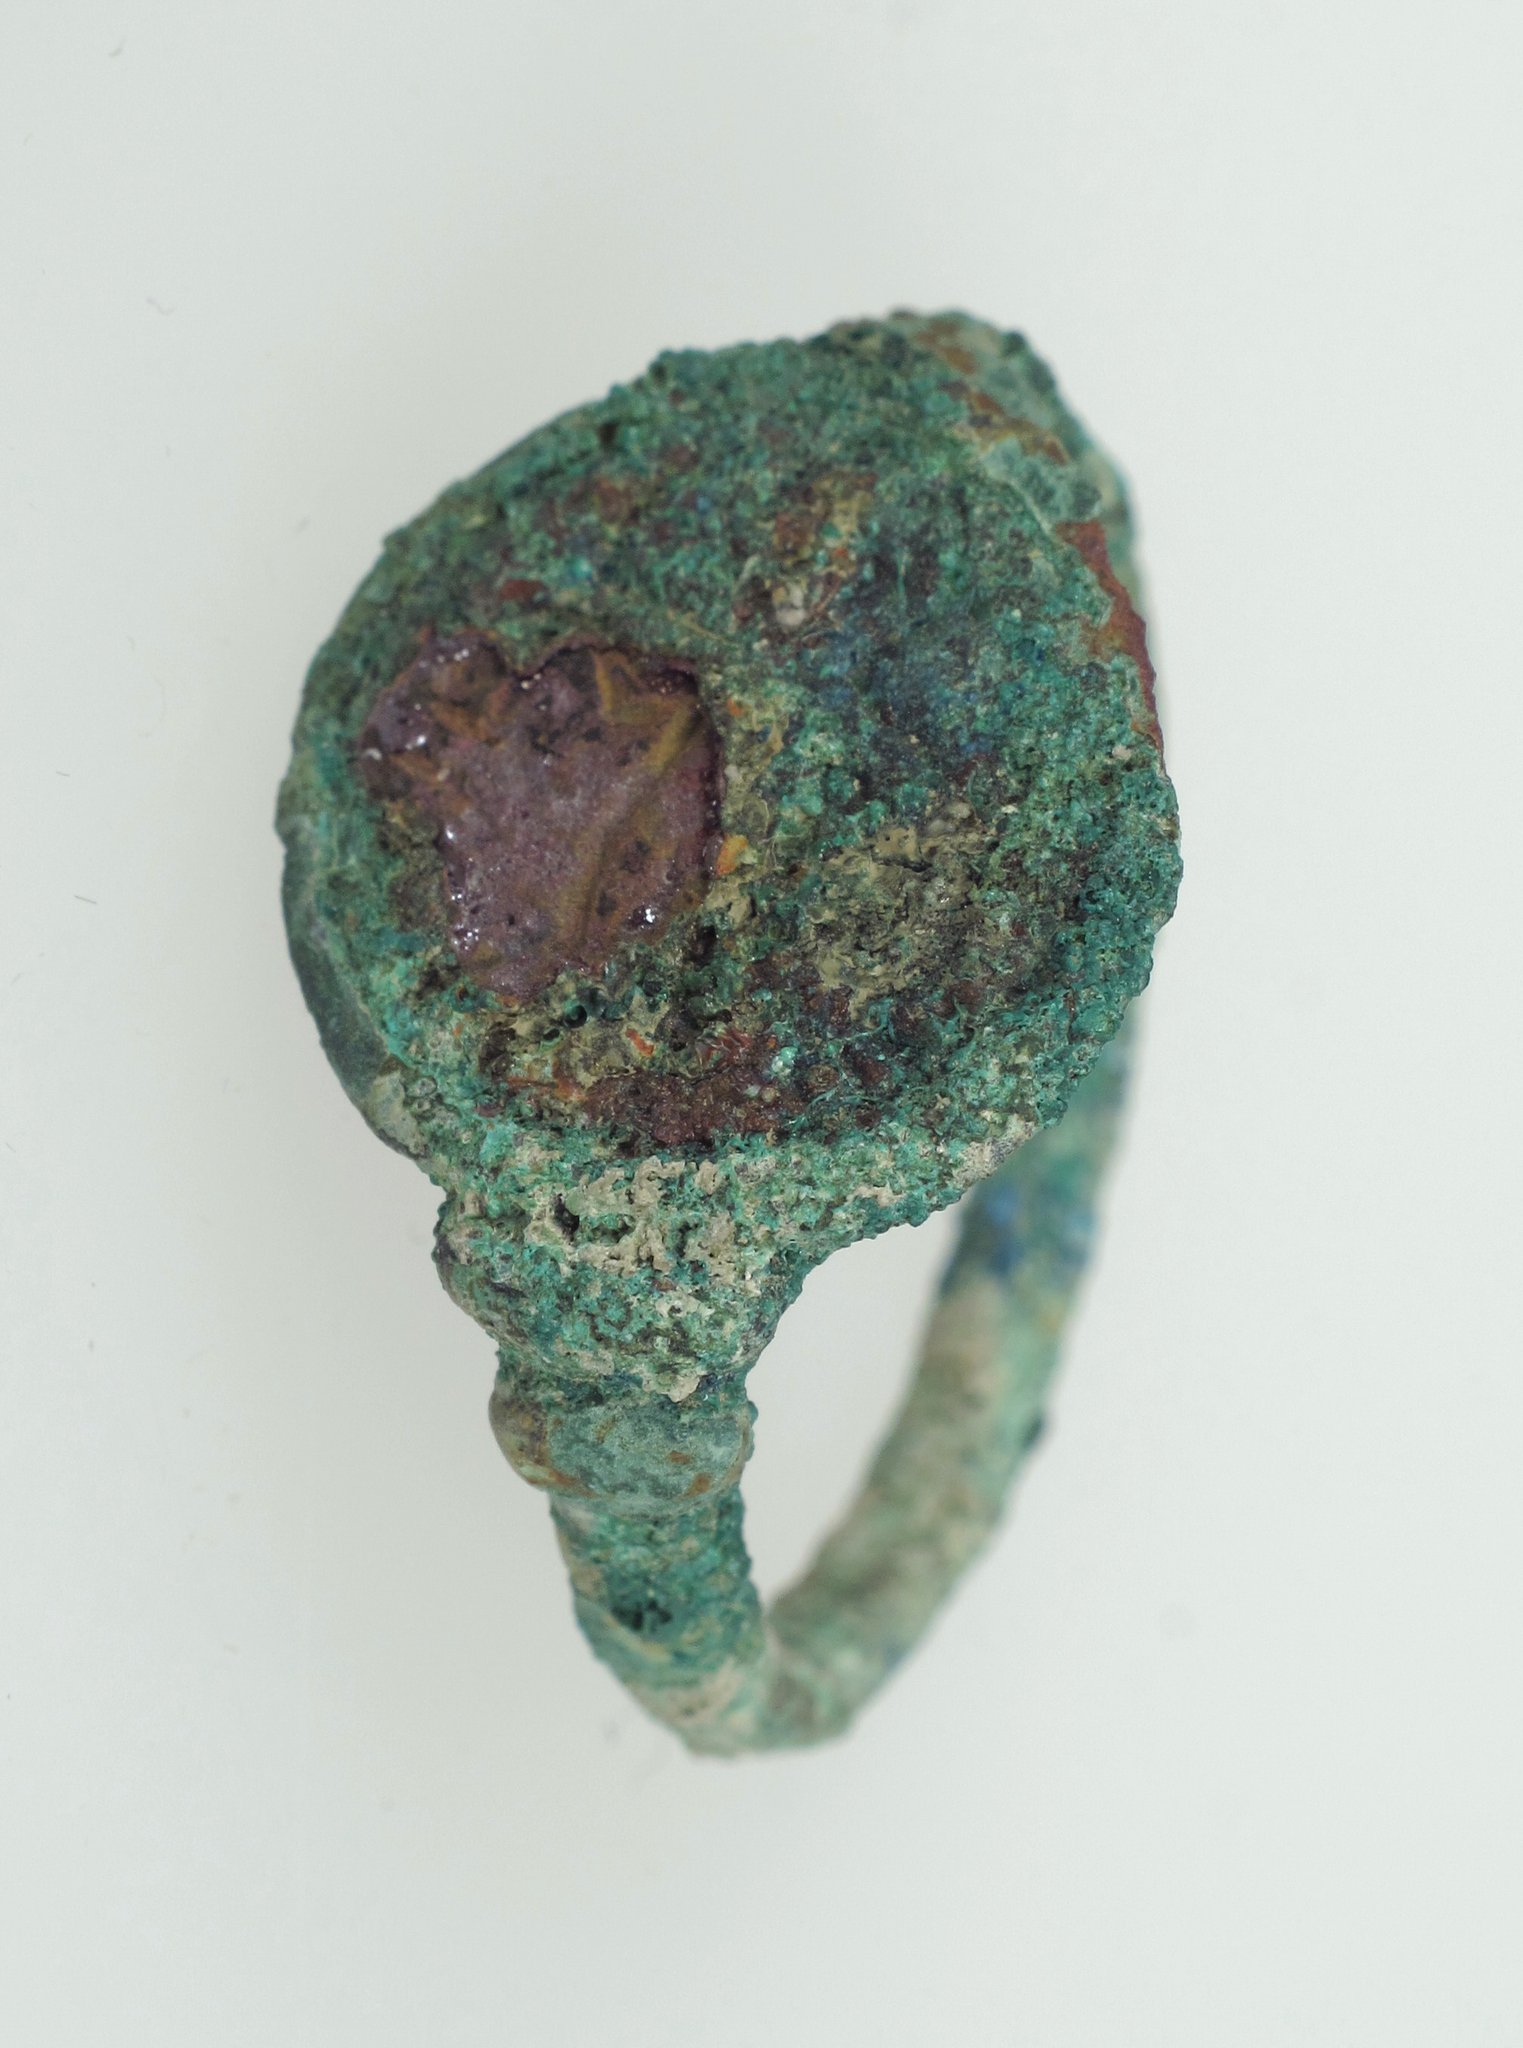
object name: ring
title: Finger Ring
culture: frankish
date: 601-700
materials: copper alloy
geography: germany